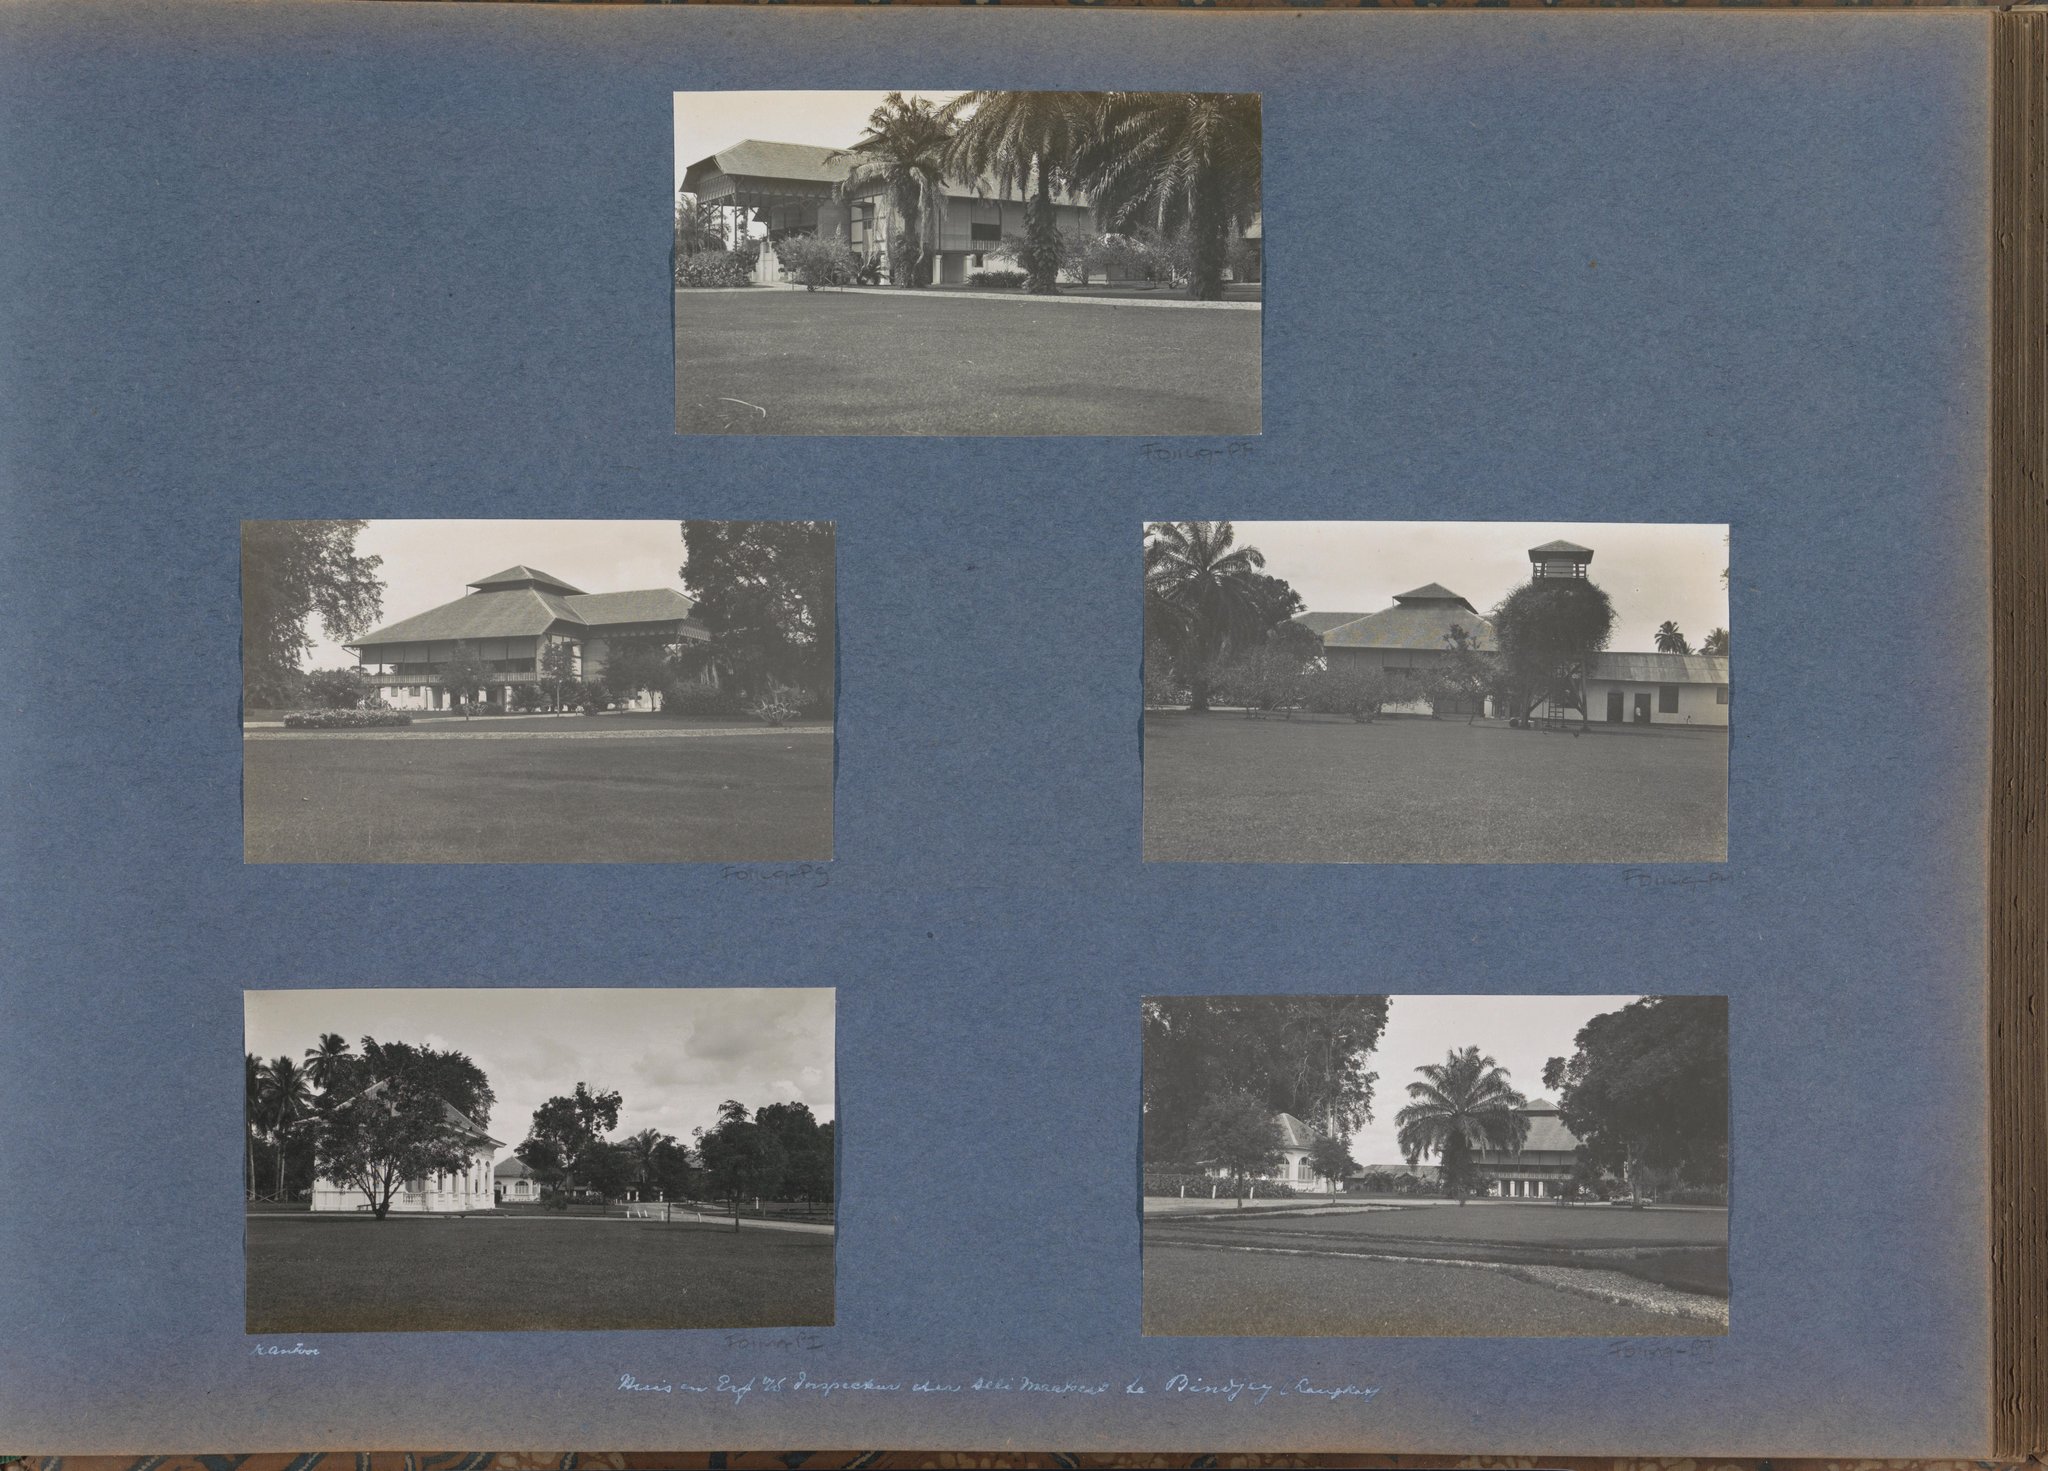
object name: photograph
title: Exterieur van het huis en het kantoor (links) van de inspecteur van de Deli Maatschappij te Bindjai Langkat op Sumatra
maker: Anonymous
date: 1900-1920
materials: paper, photographic support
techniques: gelatin silver print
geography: bindjai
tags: garden, rural housing, e.g. country-house, villa, cottage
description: Onderdeel van reisalbum met foto's van bedrijvigheid en bezienswaardigheden op Sumatra en Java en van de reis naar en van Nederlands-Indië.